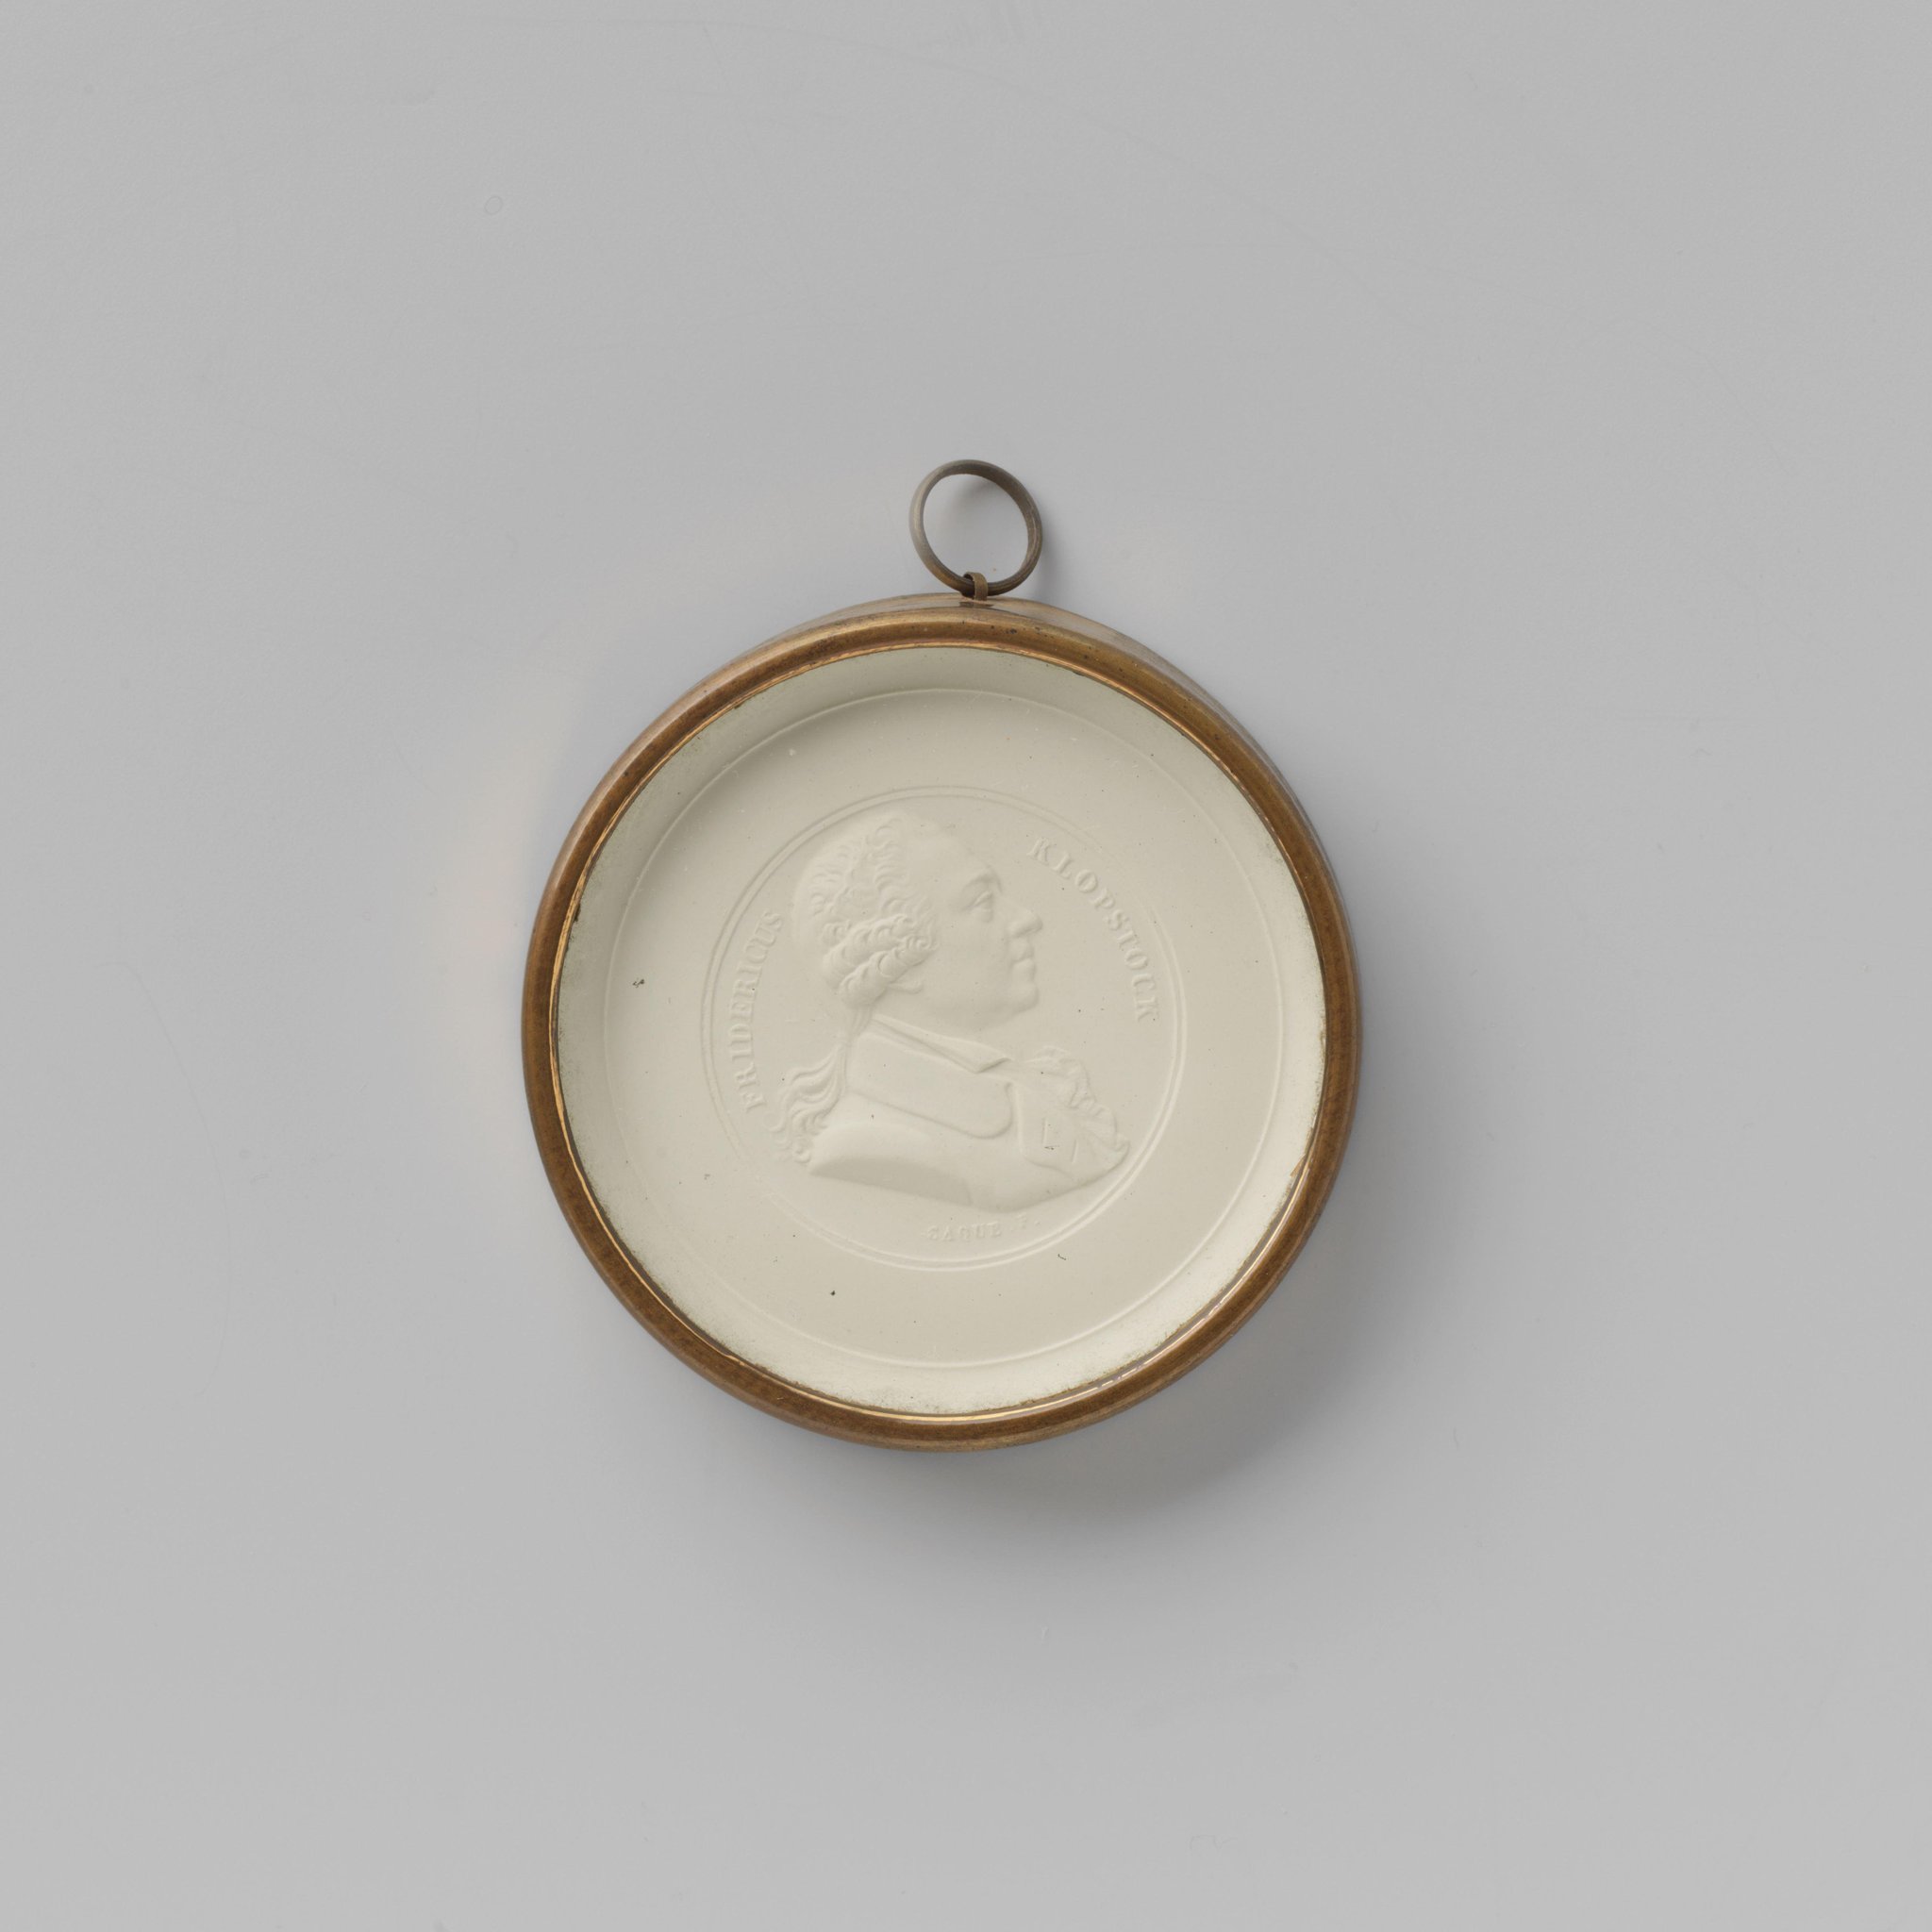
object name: locket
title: Friederich Klopstock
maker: gottfried eichler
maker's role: draughtsman, painter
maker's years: 1677-1757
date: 1820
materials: brass, glass, gypsum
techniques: casting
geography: berlin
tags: friedrich klopstock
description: Eenzijdig medaillon in messing ring achter glas aan draagoog en draagring. Voorzijde: borststuk man naar rechts binnen omschrift. Keerzijde: etiket met opschrift.